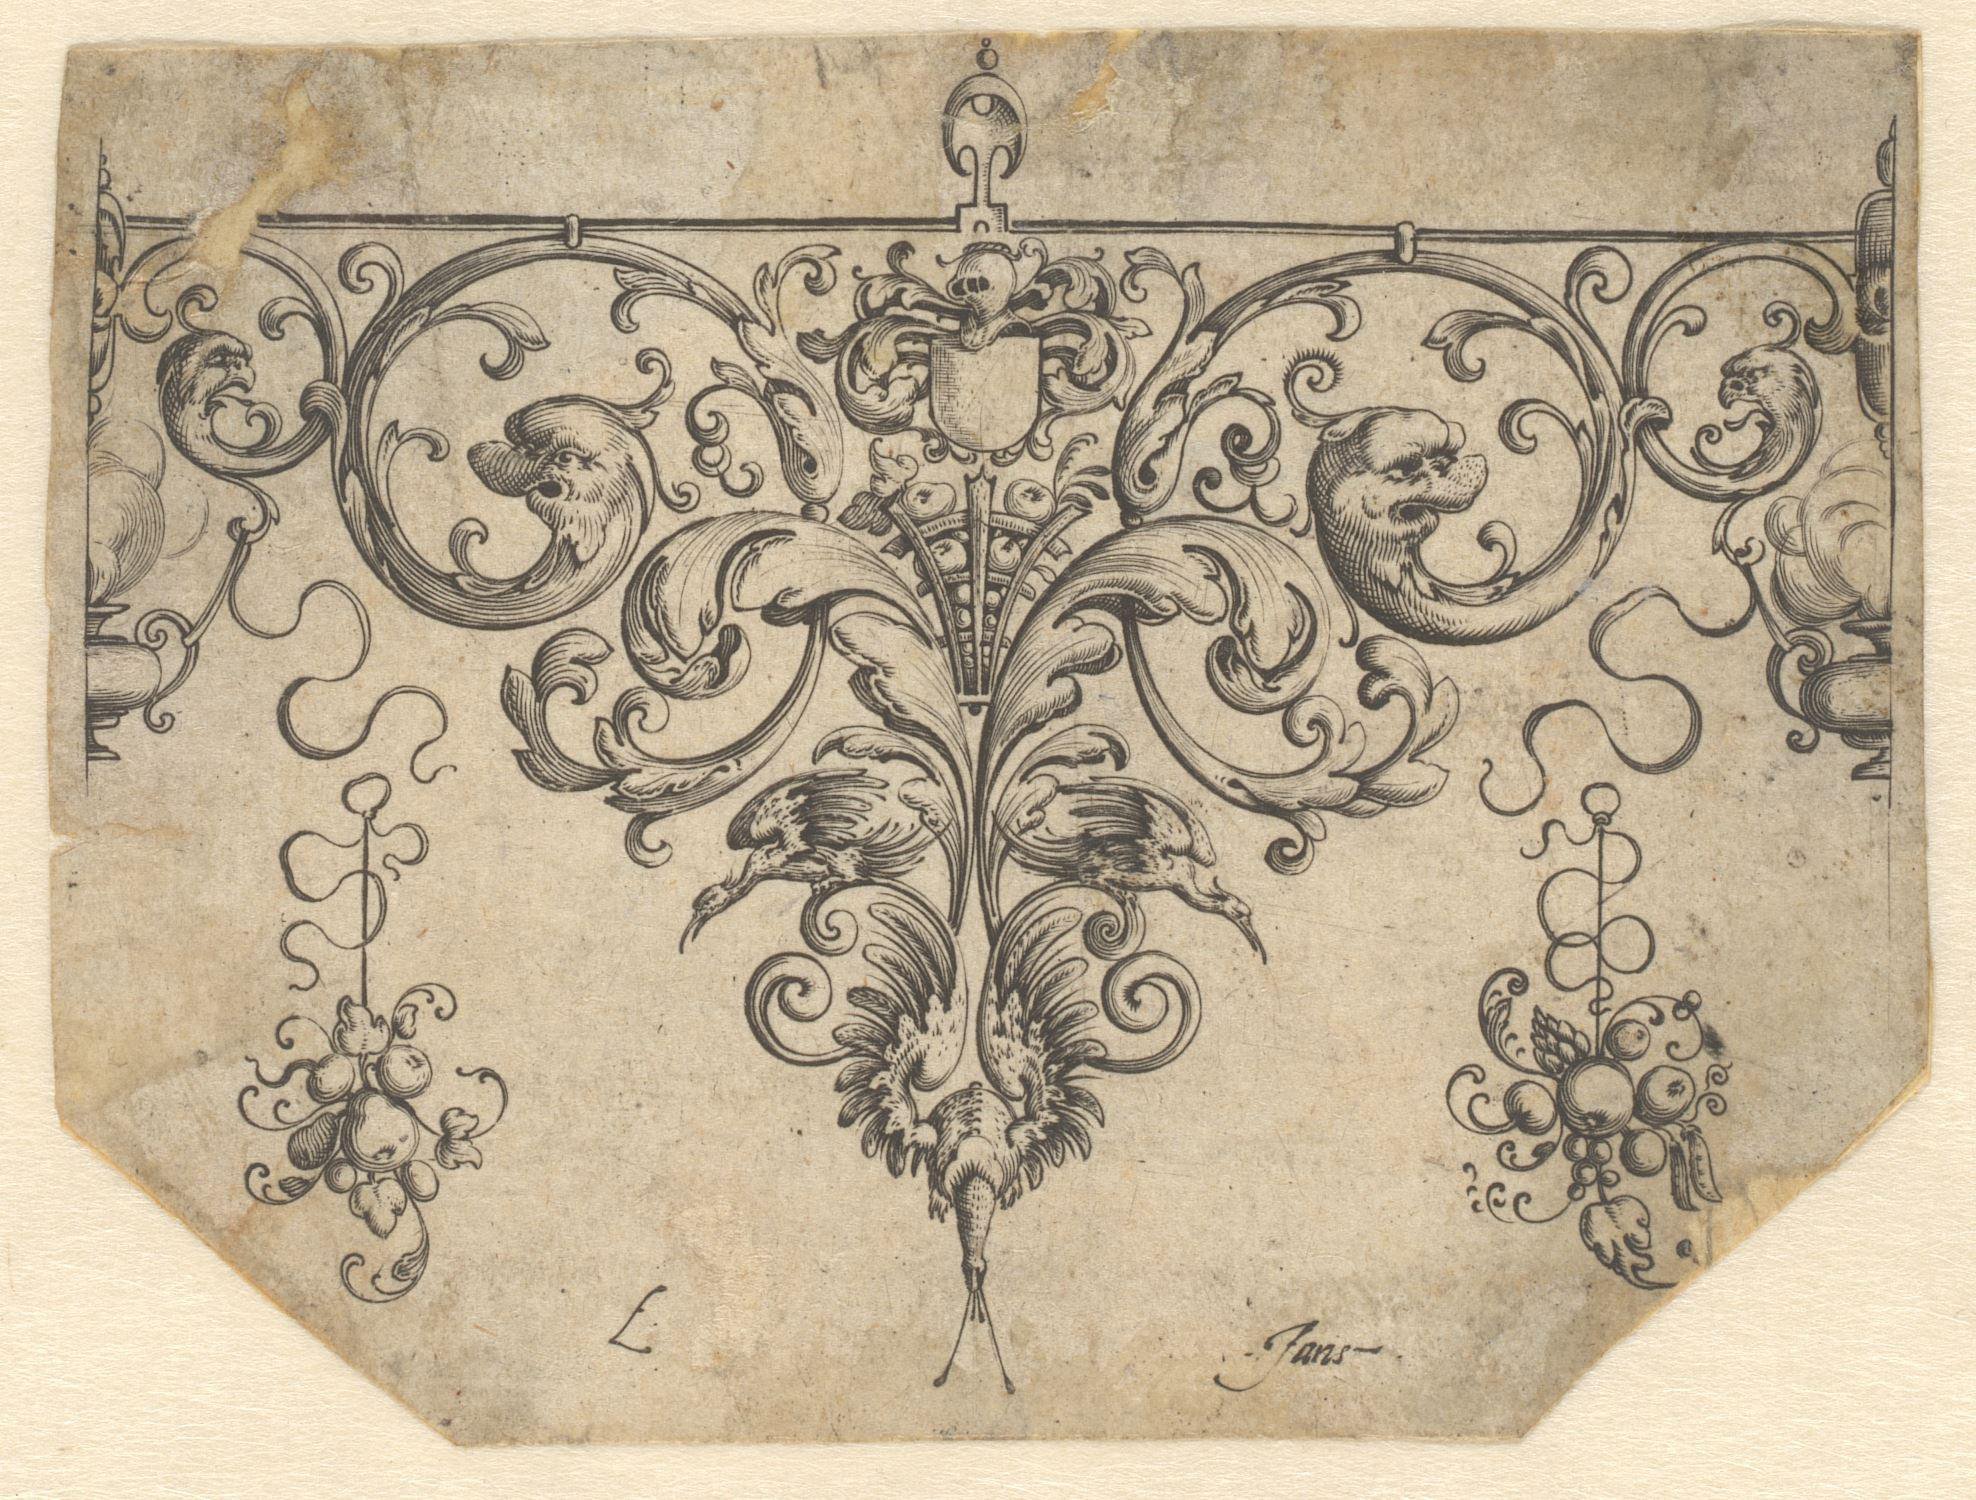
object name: ornament print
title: Spits met ranken, leeg wapenschild en een slak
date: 1631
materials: paper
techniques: etching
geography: amsterdam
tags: coat of arms (symbol of sovereignty), ornaments ~ art, foliage ~ ornament, molluscs: snail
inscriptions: collector's mark: Lugt 2228, collector's mark: Lugt 2760, signature: ‘Jans’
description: Mogelijk een blad uit serie met decoraties voor zilveren bekers.